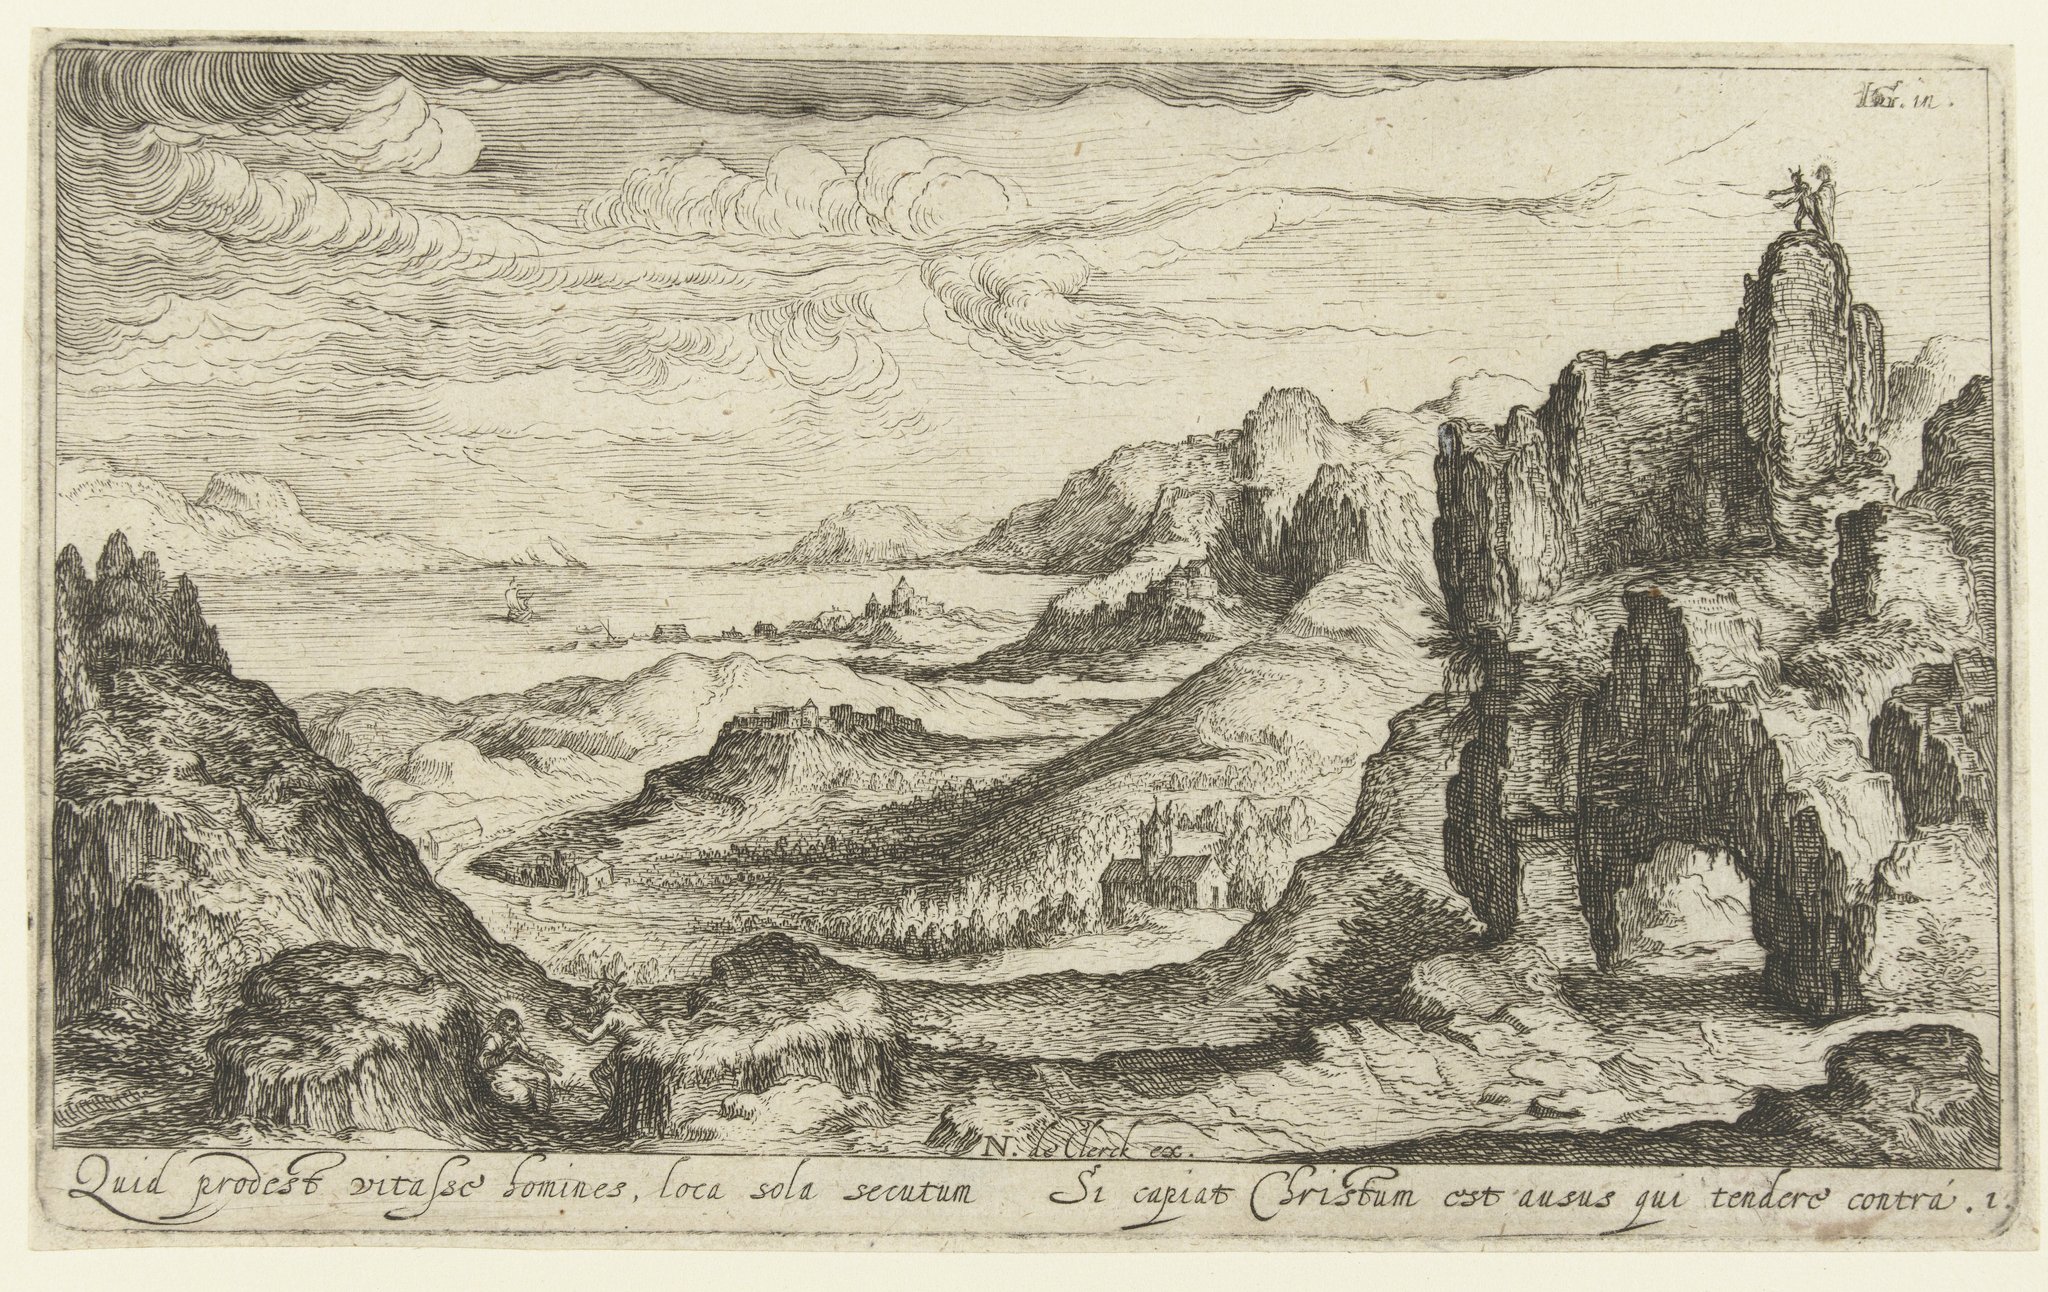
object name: print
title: Landschap met de verzoeking van Christus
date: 1608-1612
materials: paper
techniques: engraving, etching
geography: delft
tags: landscapes, christ, sometimes accompanied by guardian angel(s), tempted by satan, who usually appears in human form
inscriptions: collector's mark: Lugt 240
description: Bergachtig landschap aan een water. Links Satan tegenover Christus. Rechts Christus en Satan staand op een bergtop. Onder de voorstelling één regel Latijnse tekst. Deze prent is onderdeel van een serie van zes (op één na) genummerde prenten met landschappen.